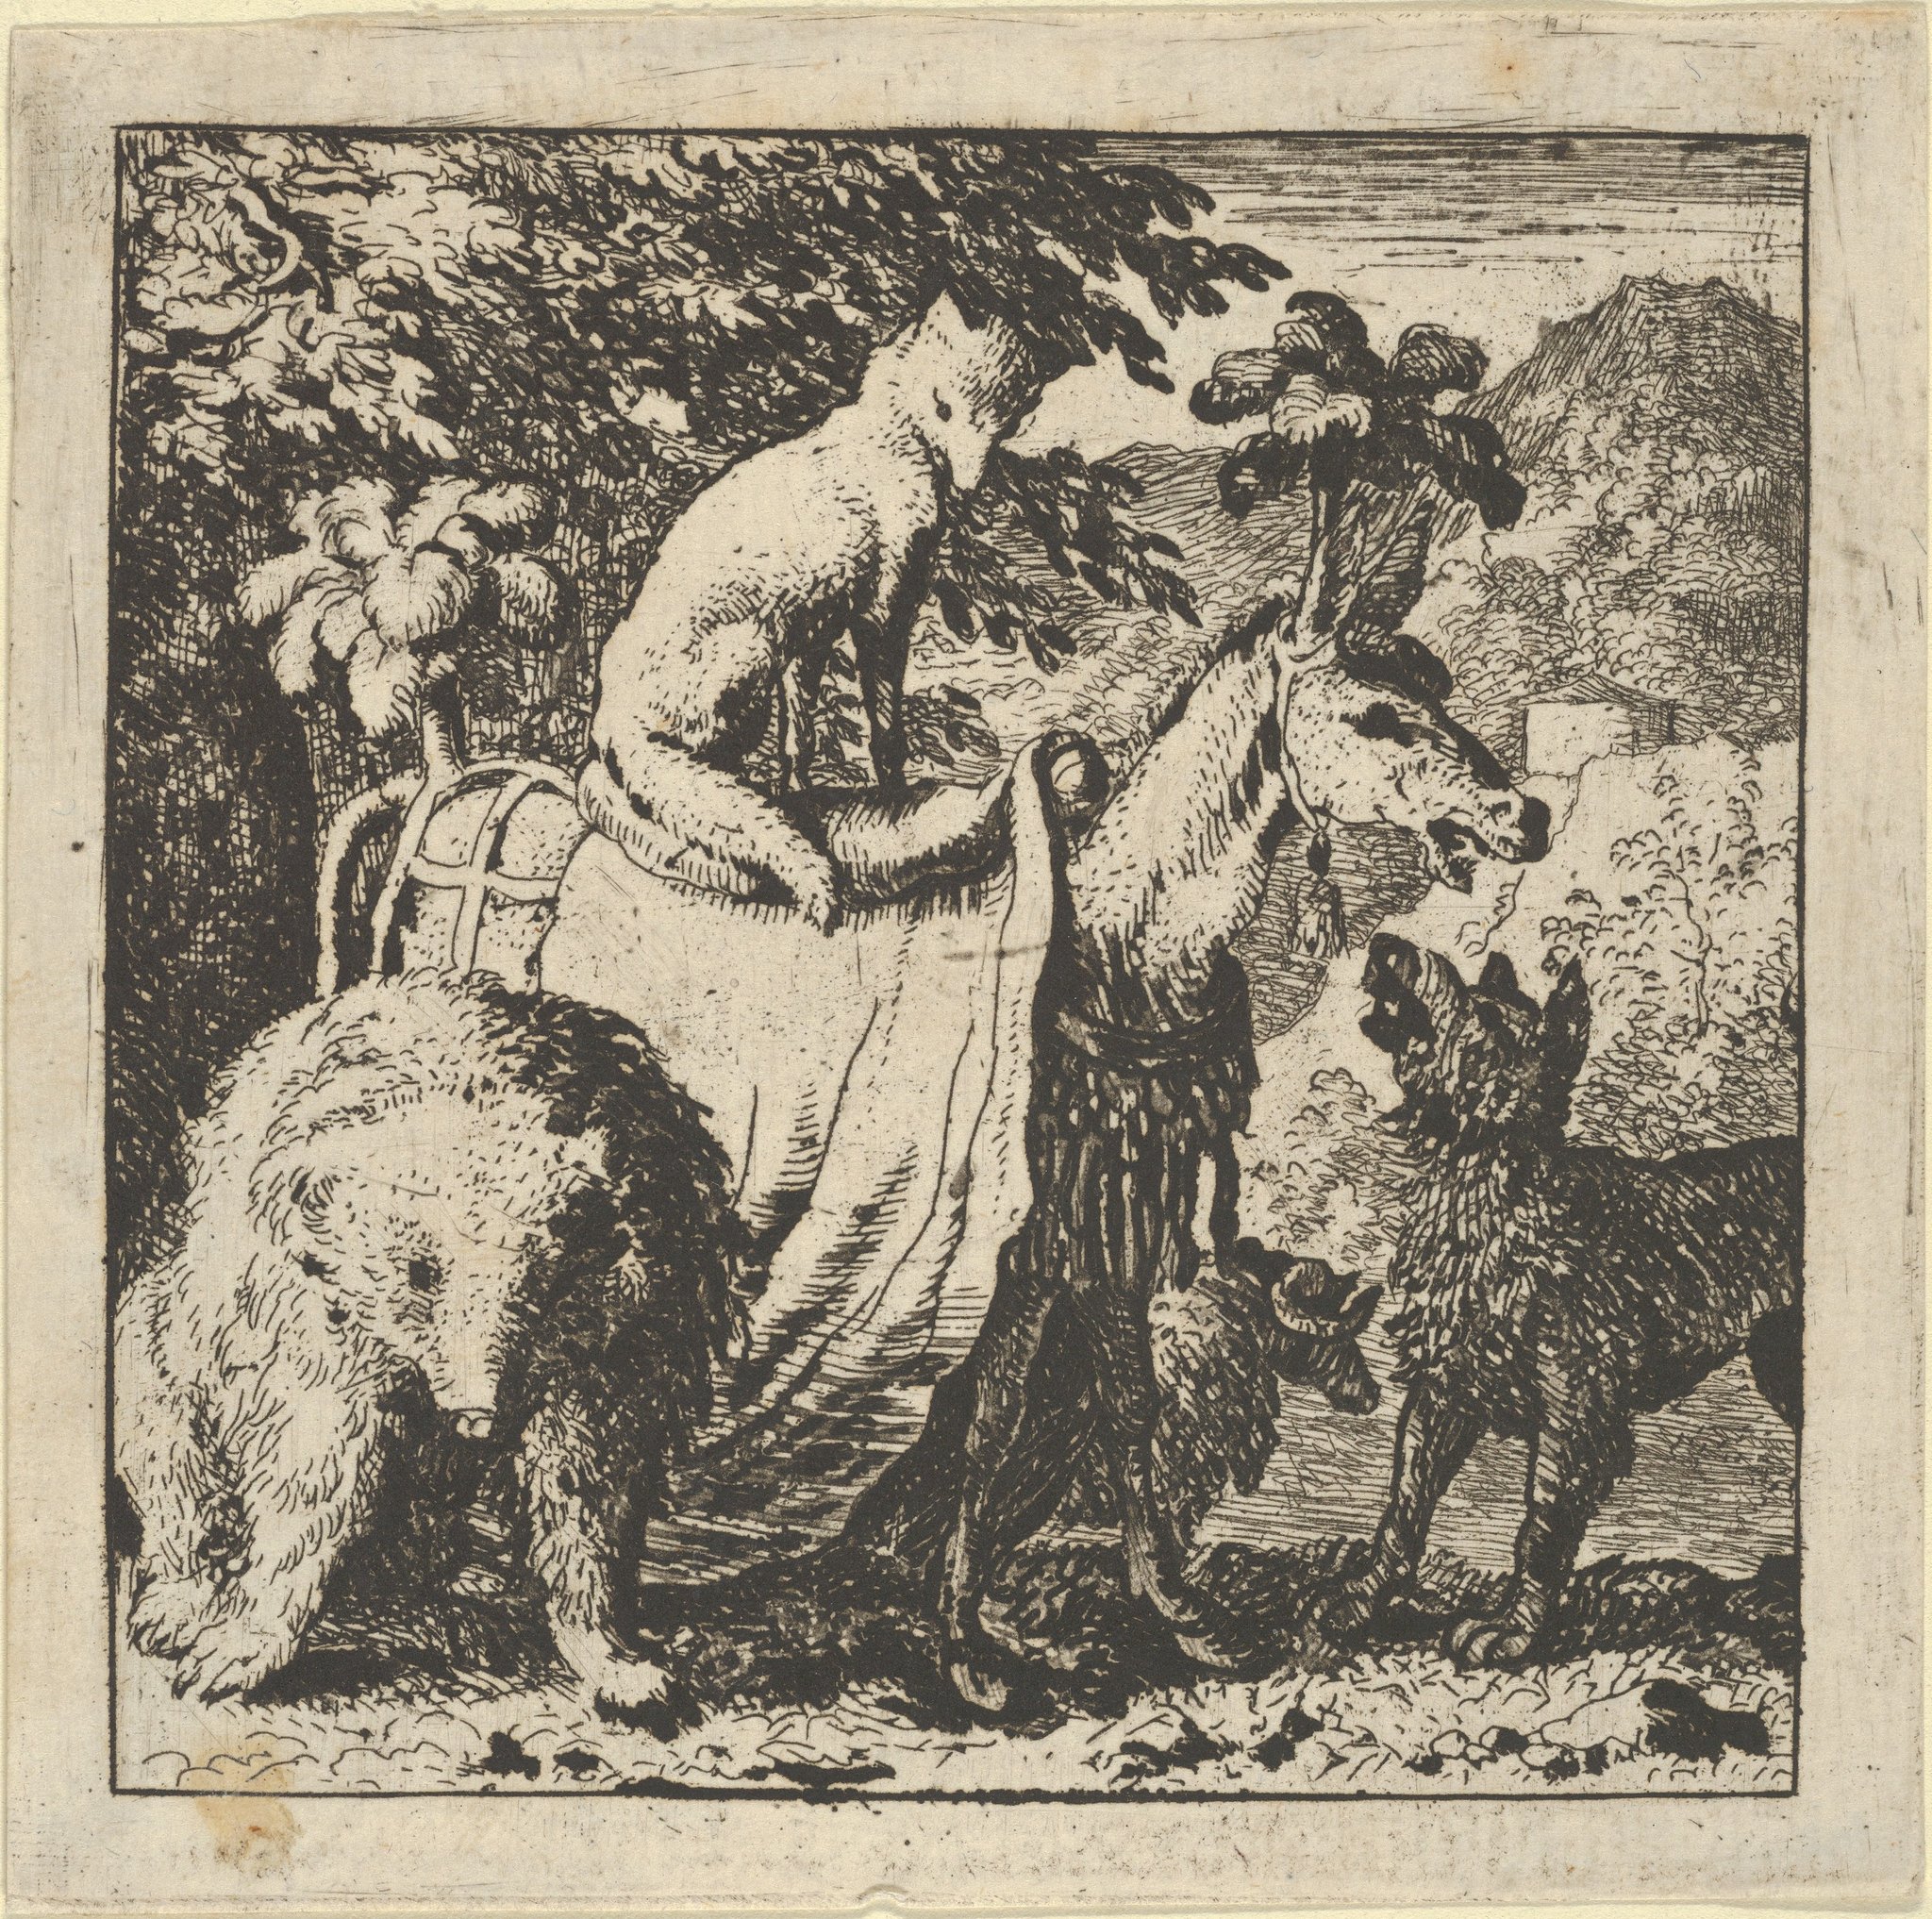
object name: print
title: Renard Mounted on an Ass from Hendrick van Alcmar's Renard The Fox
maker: allart van everdingen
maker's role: artist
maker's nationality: dutch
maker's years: 1621-1675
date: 1650-1675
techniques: engraving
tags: bears,dogs,donkeys,foxes